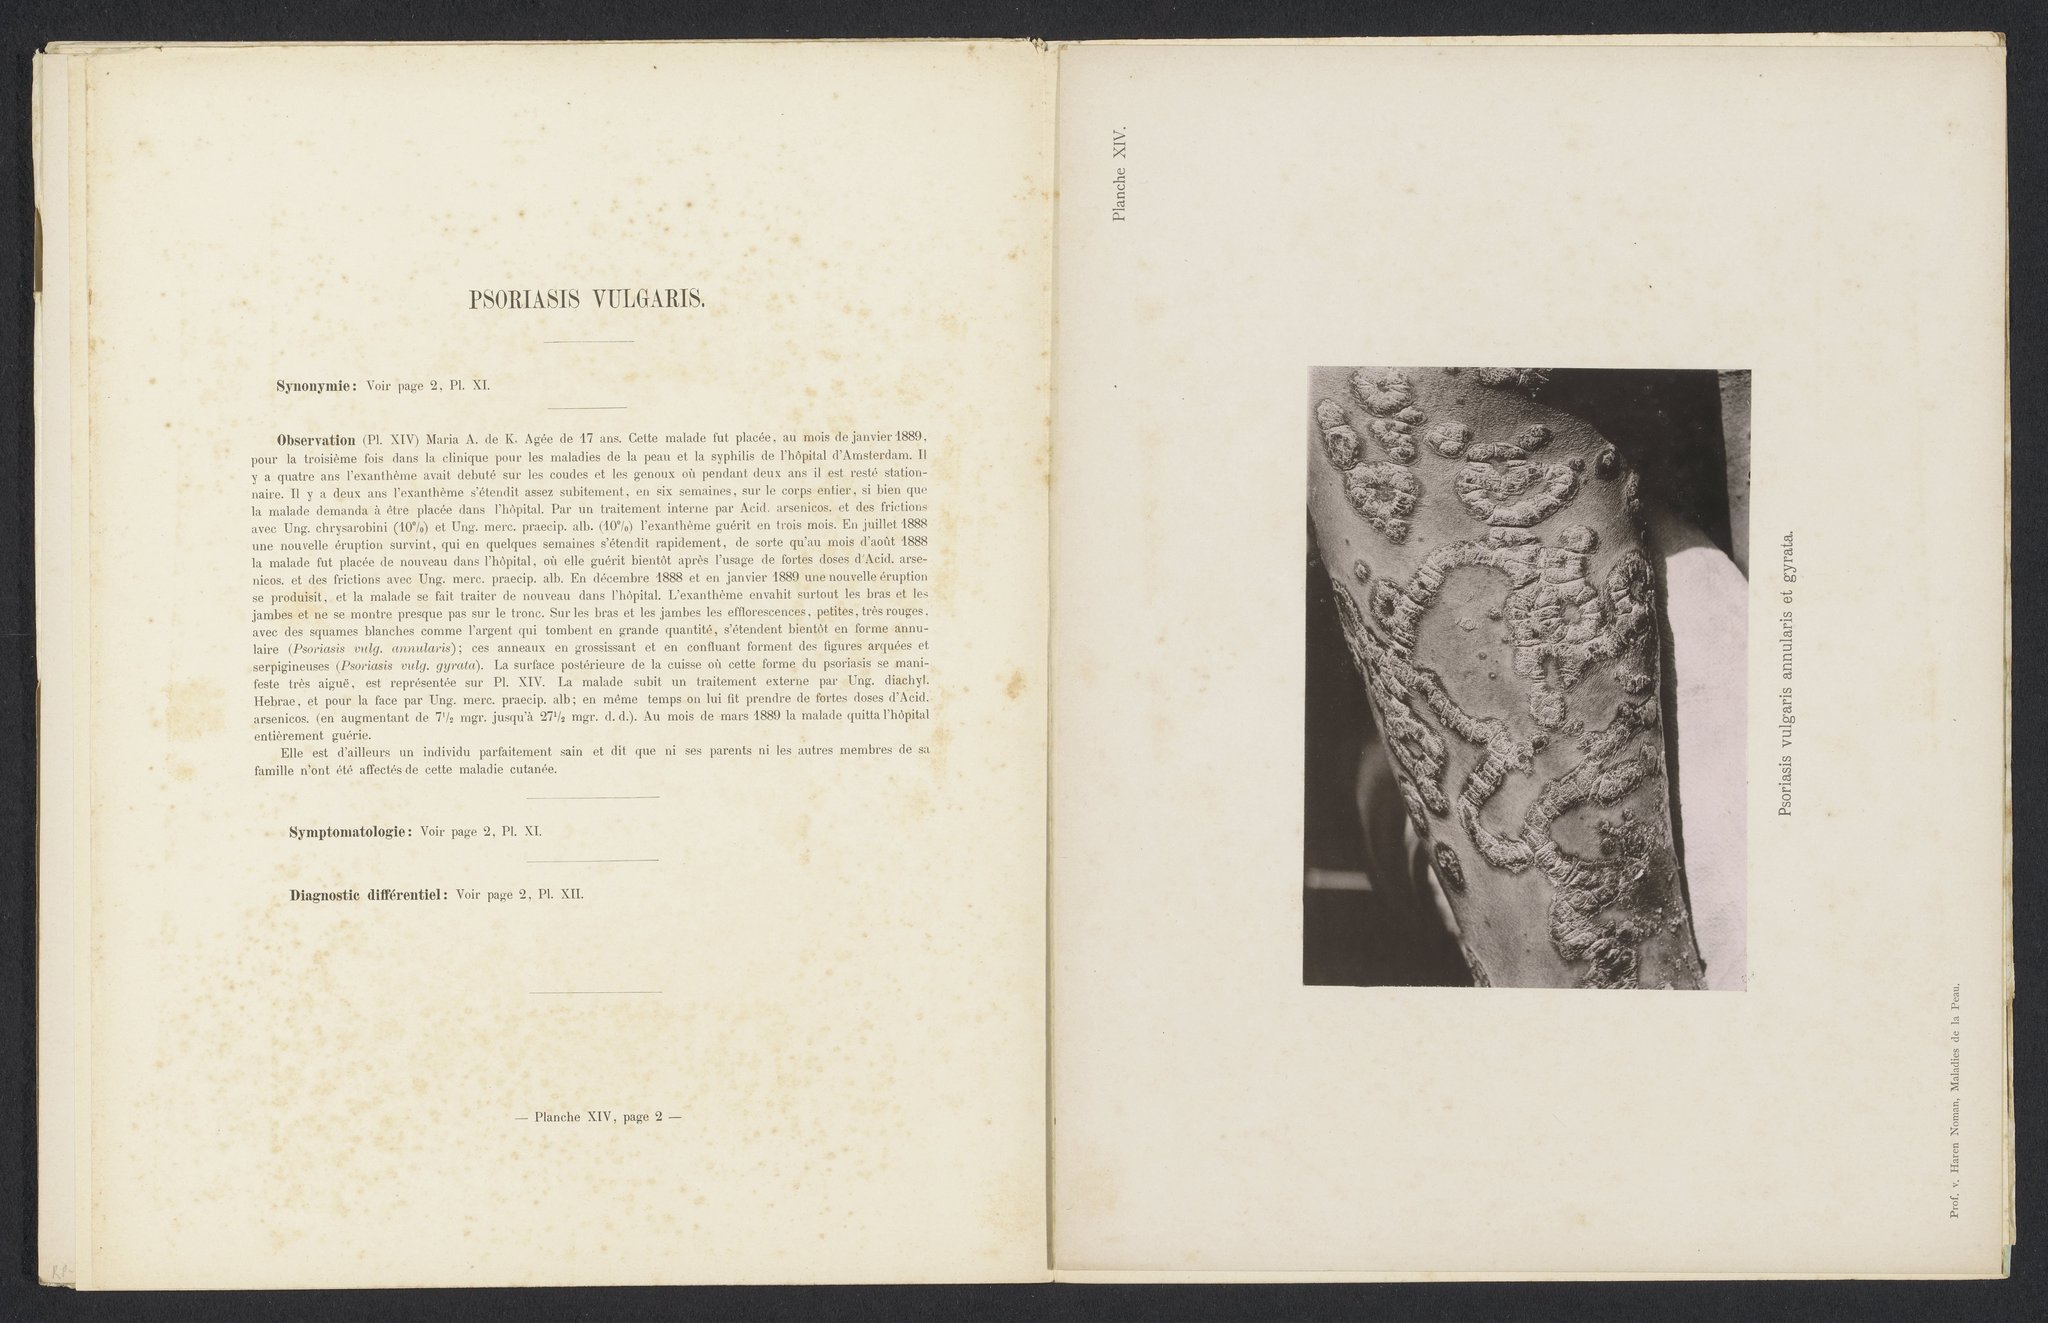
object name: photomechanical print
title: Patiënt lijdend aan de huidziekte 'psoriasis vulgaris annularis et gyrata'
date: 1880-1889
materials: paper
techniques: photograph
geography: haarlem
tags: skin and venereal diseases, arms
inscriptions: number: ‘Planche XIV.’